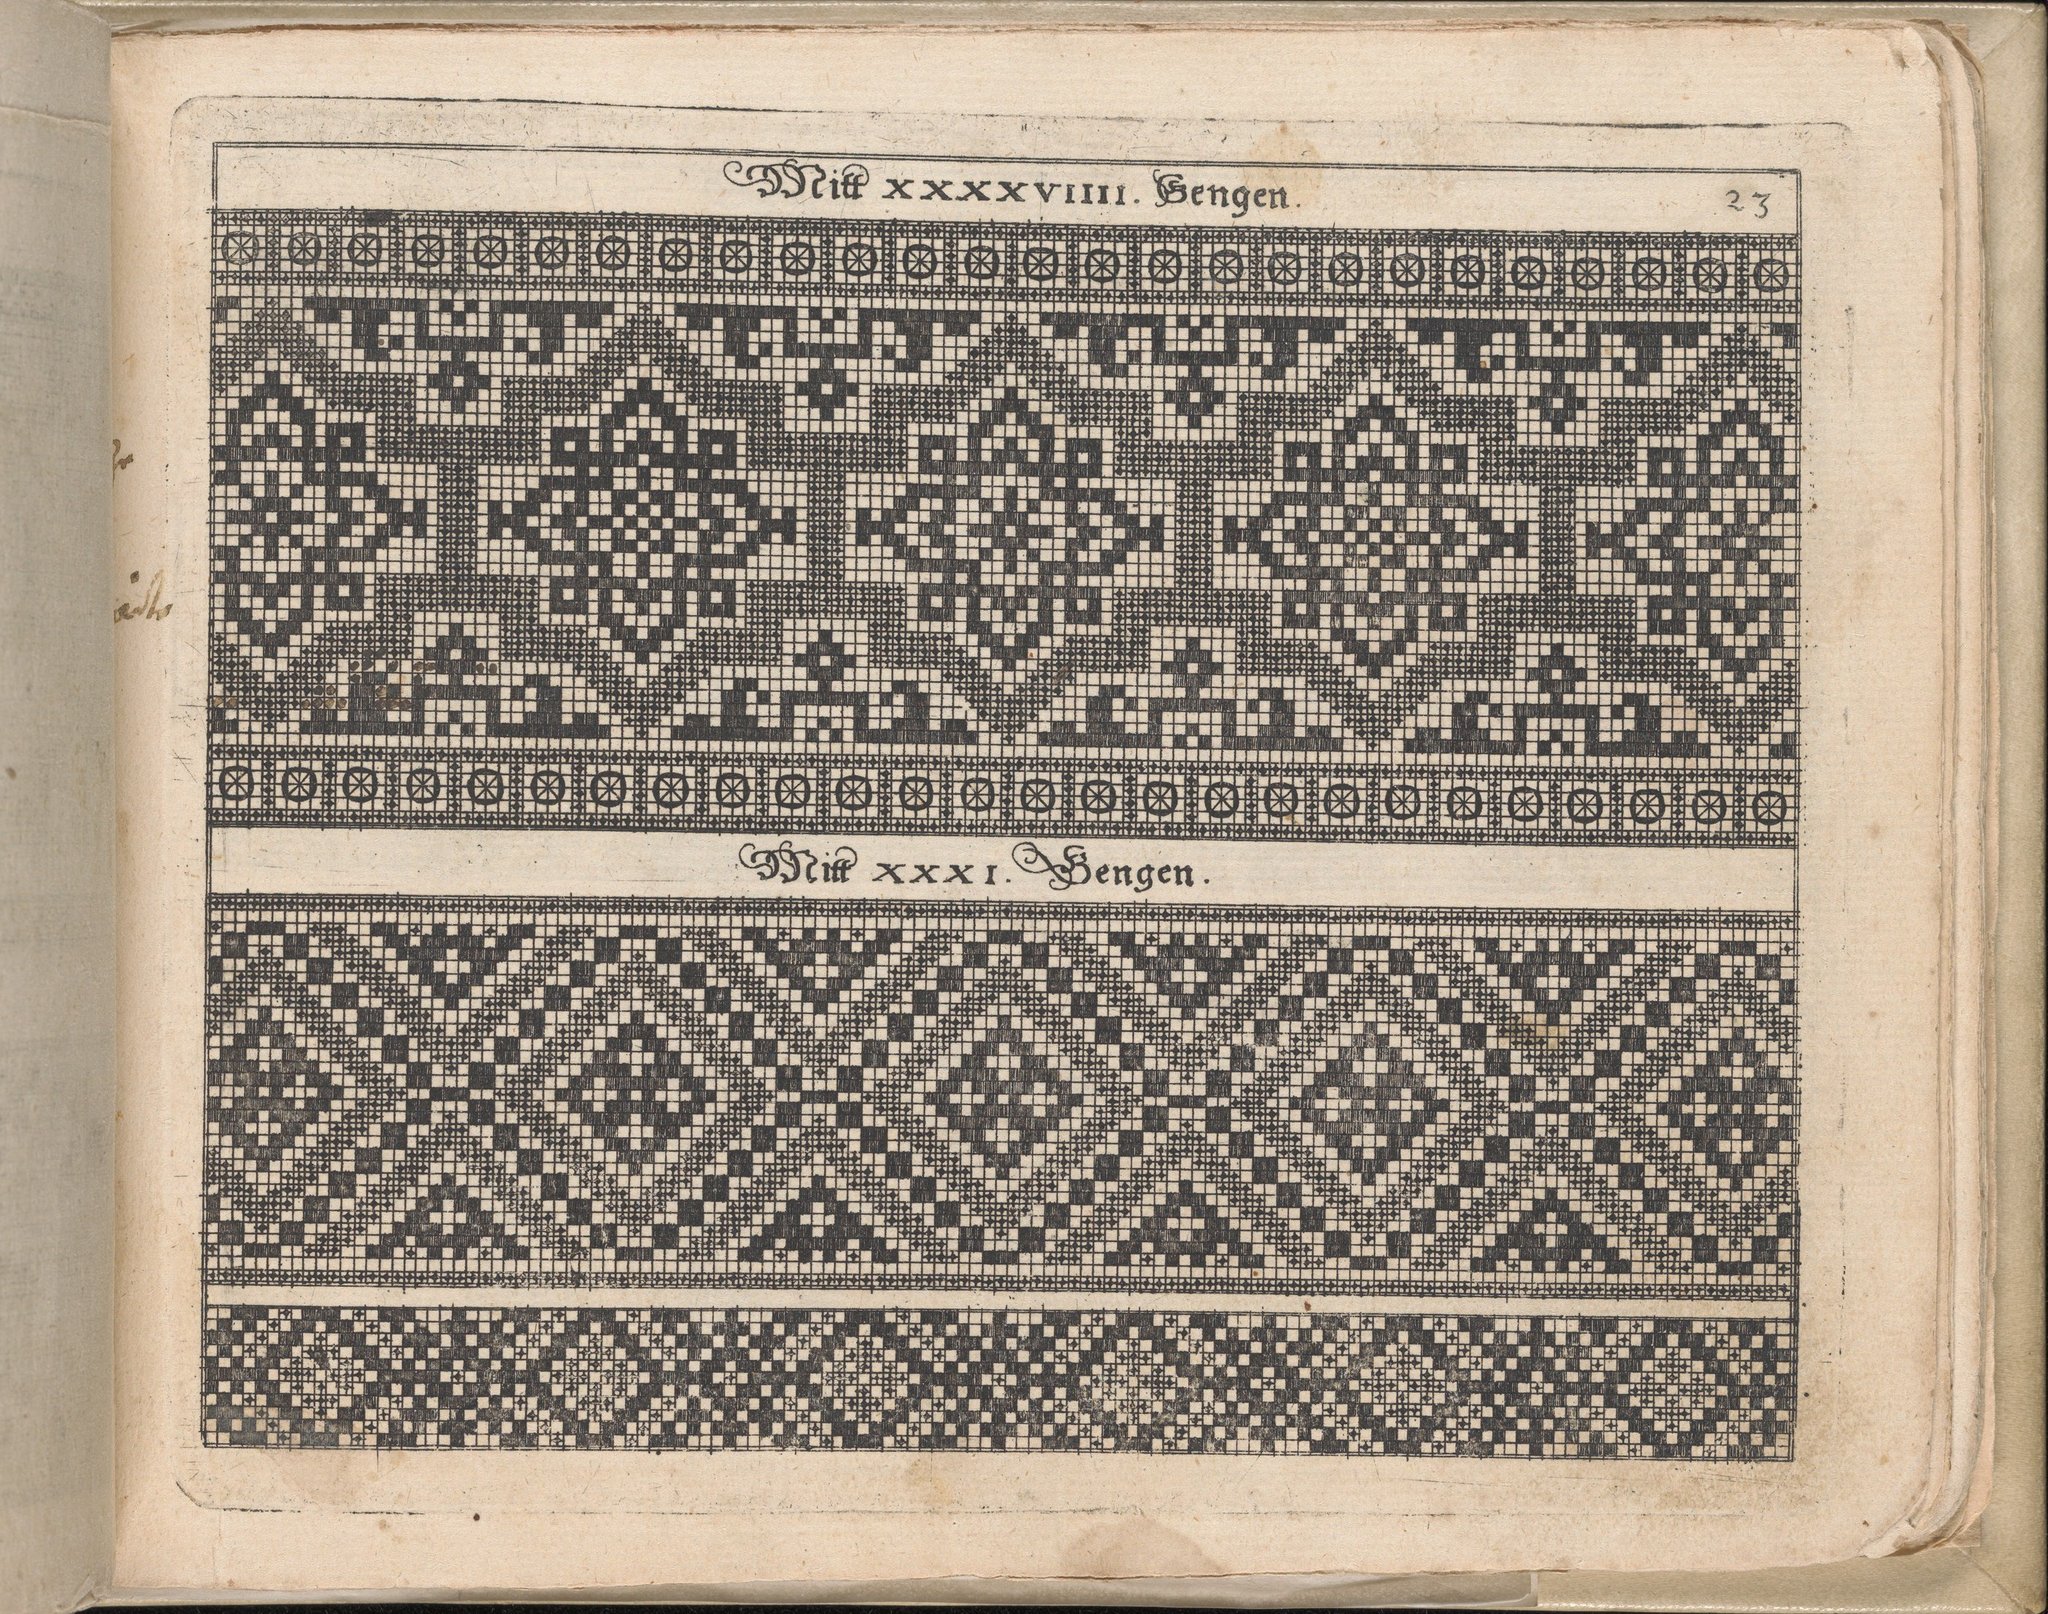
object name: book print ornament architecture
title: Schön Neues Modelbuch (Page 28 recto)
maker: johann sibmacher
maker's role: designer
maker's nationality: german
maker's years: 1590-1611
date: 1597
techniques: etching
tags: ornament